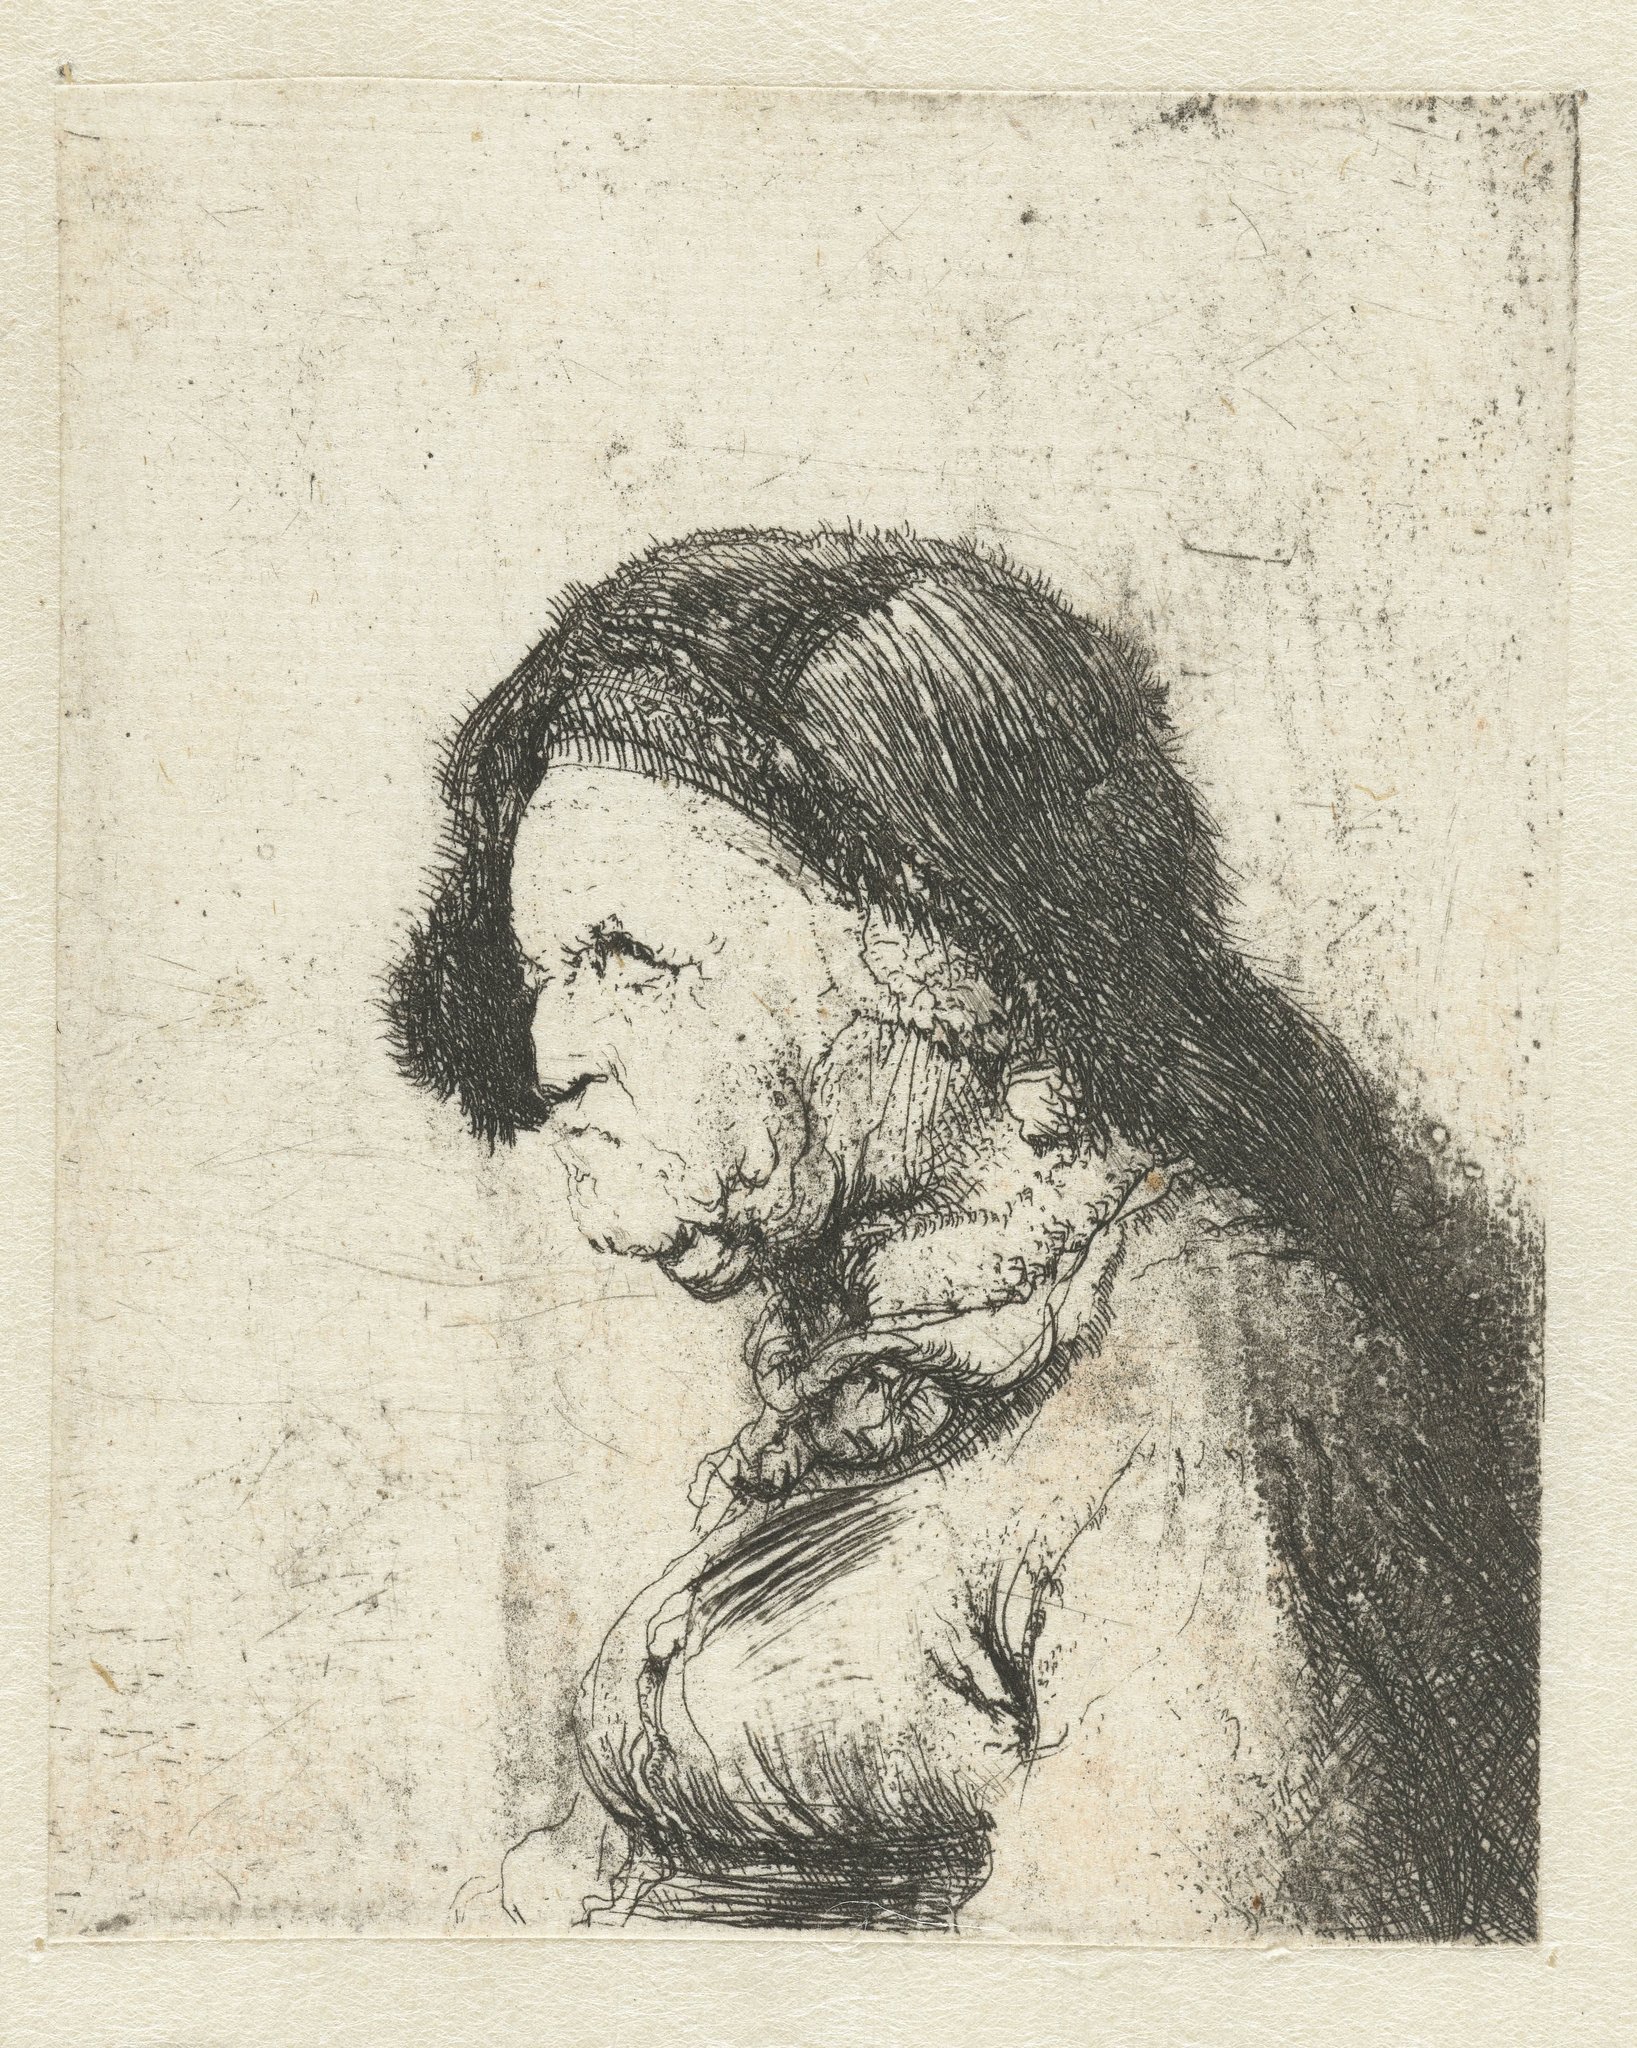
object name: print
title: Borstbeeld van een oude vrouw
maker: jan lievens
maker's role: draughtsman, painter, print maker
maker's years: 1607-1674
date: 1625-1674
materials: paper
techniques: etching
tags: old woman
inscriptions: collector's mark: Lugt 240